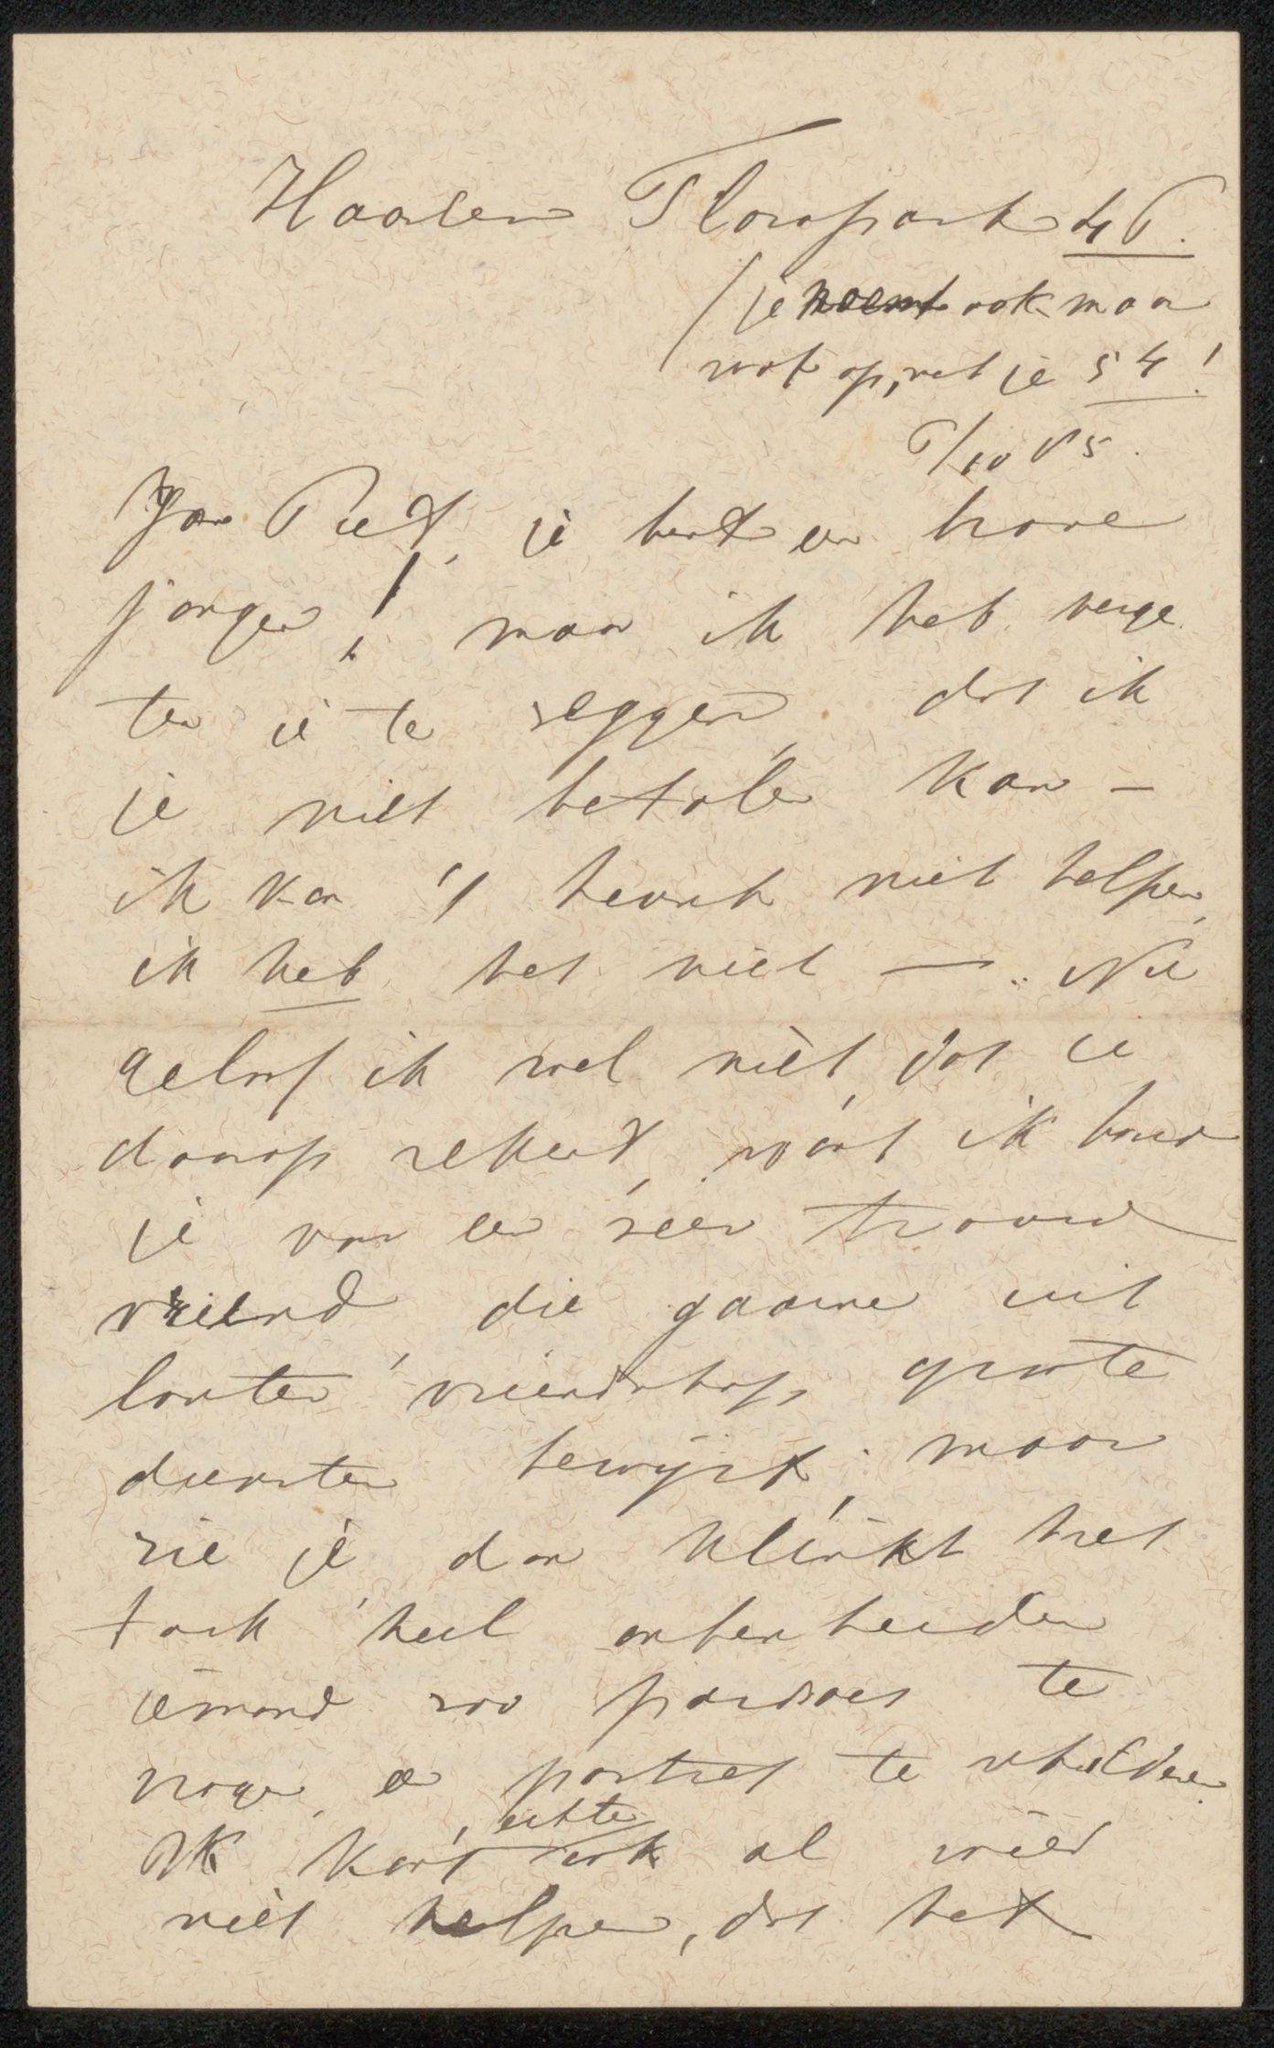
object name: letter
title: Brief aan Jan Veth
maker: martha van vloten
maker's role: vertaler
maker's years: 1856-1943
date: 1885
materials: ink, paper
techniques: pen, writing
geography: haarlem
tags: dordrecht, amsterdam, painter, draughtsman, designer, jan veth, frank van der goes, haarlem, frederik van eeden, artist's model, sitter, painting (including book-illumination, miniature-painting), historical persons (portraits and scenes from the life), money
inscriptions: collector's mark: ‘RPK’